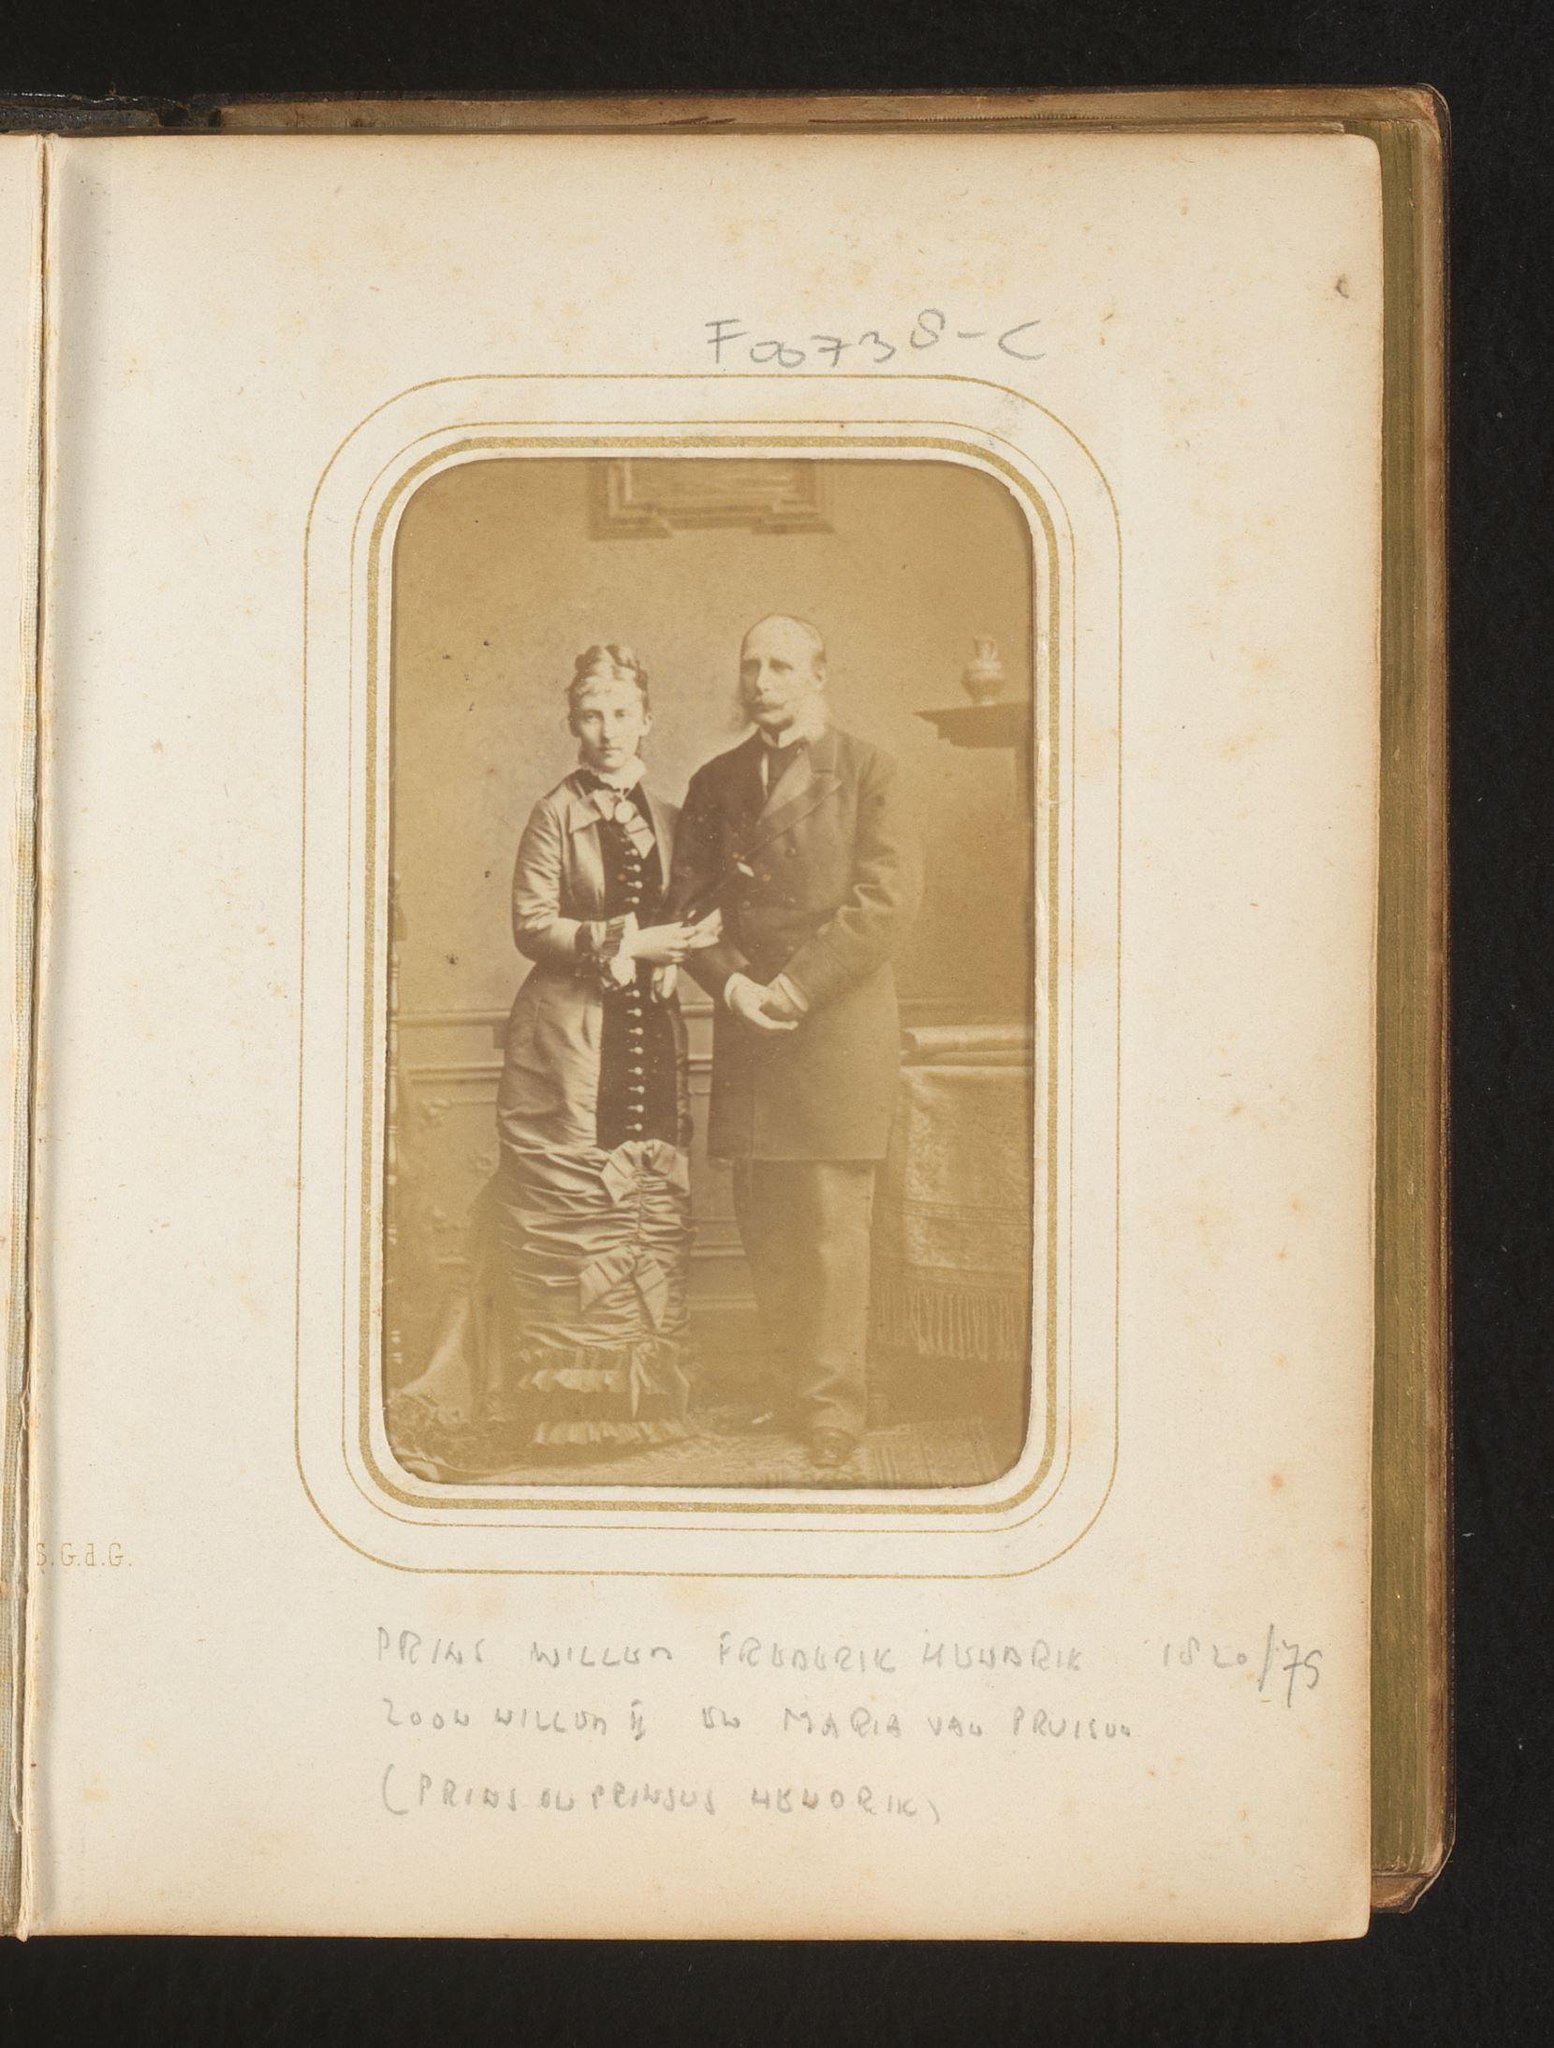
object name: album leaf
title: Portret van prins Hendrik van Oranje-Nassau en prinses Maria van Pruisen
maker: Anonymous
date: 1870-1879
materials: cardboard, photographic support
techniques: albumen print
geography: netherlands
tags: hendrik (prins der nederlanden), historical persons - bb - woman, prince, historical persons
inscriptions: inscription: ‘Beveté S.G.d.G.’, inscription: ‘334 HH. KK. HH. Prins en Prinses/ Hendrik der Nederlanden.’, annotation: ‘Prins Willem Frederik Hendrik 1820/75/ zoon Willem II en Maria van Pruisen/ (Prins en Prinses Hendrik)’